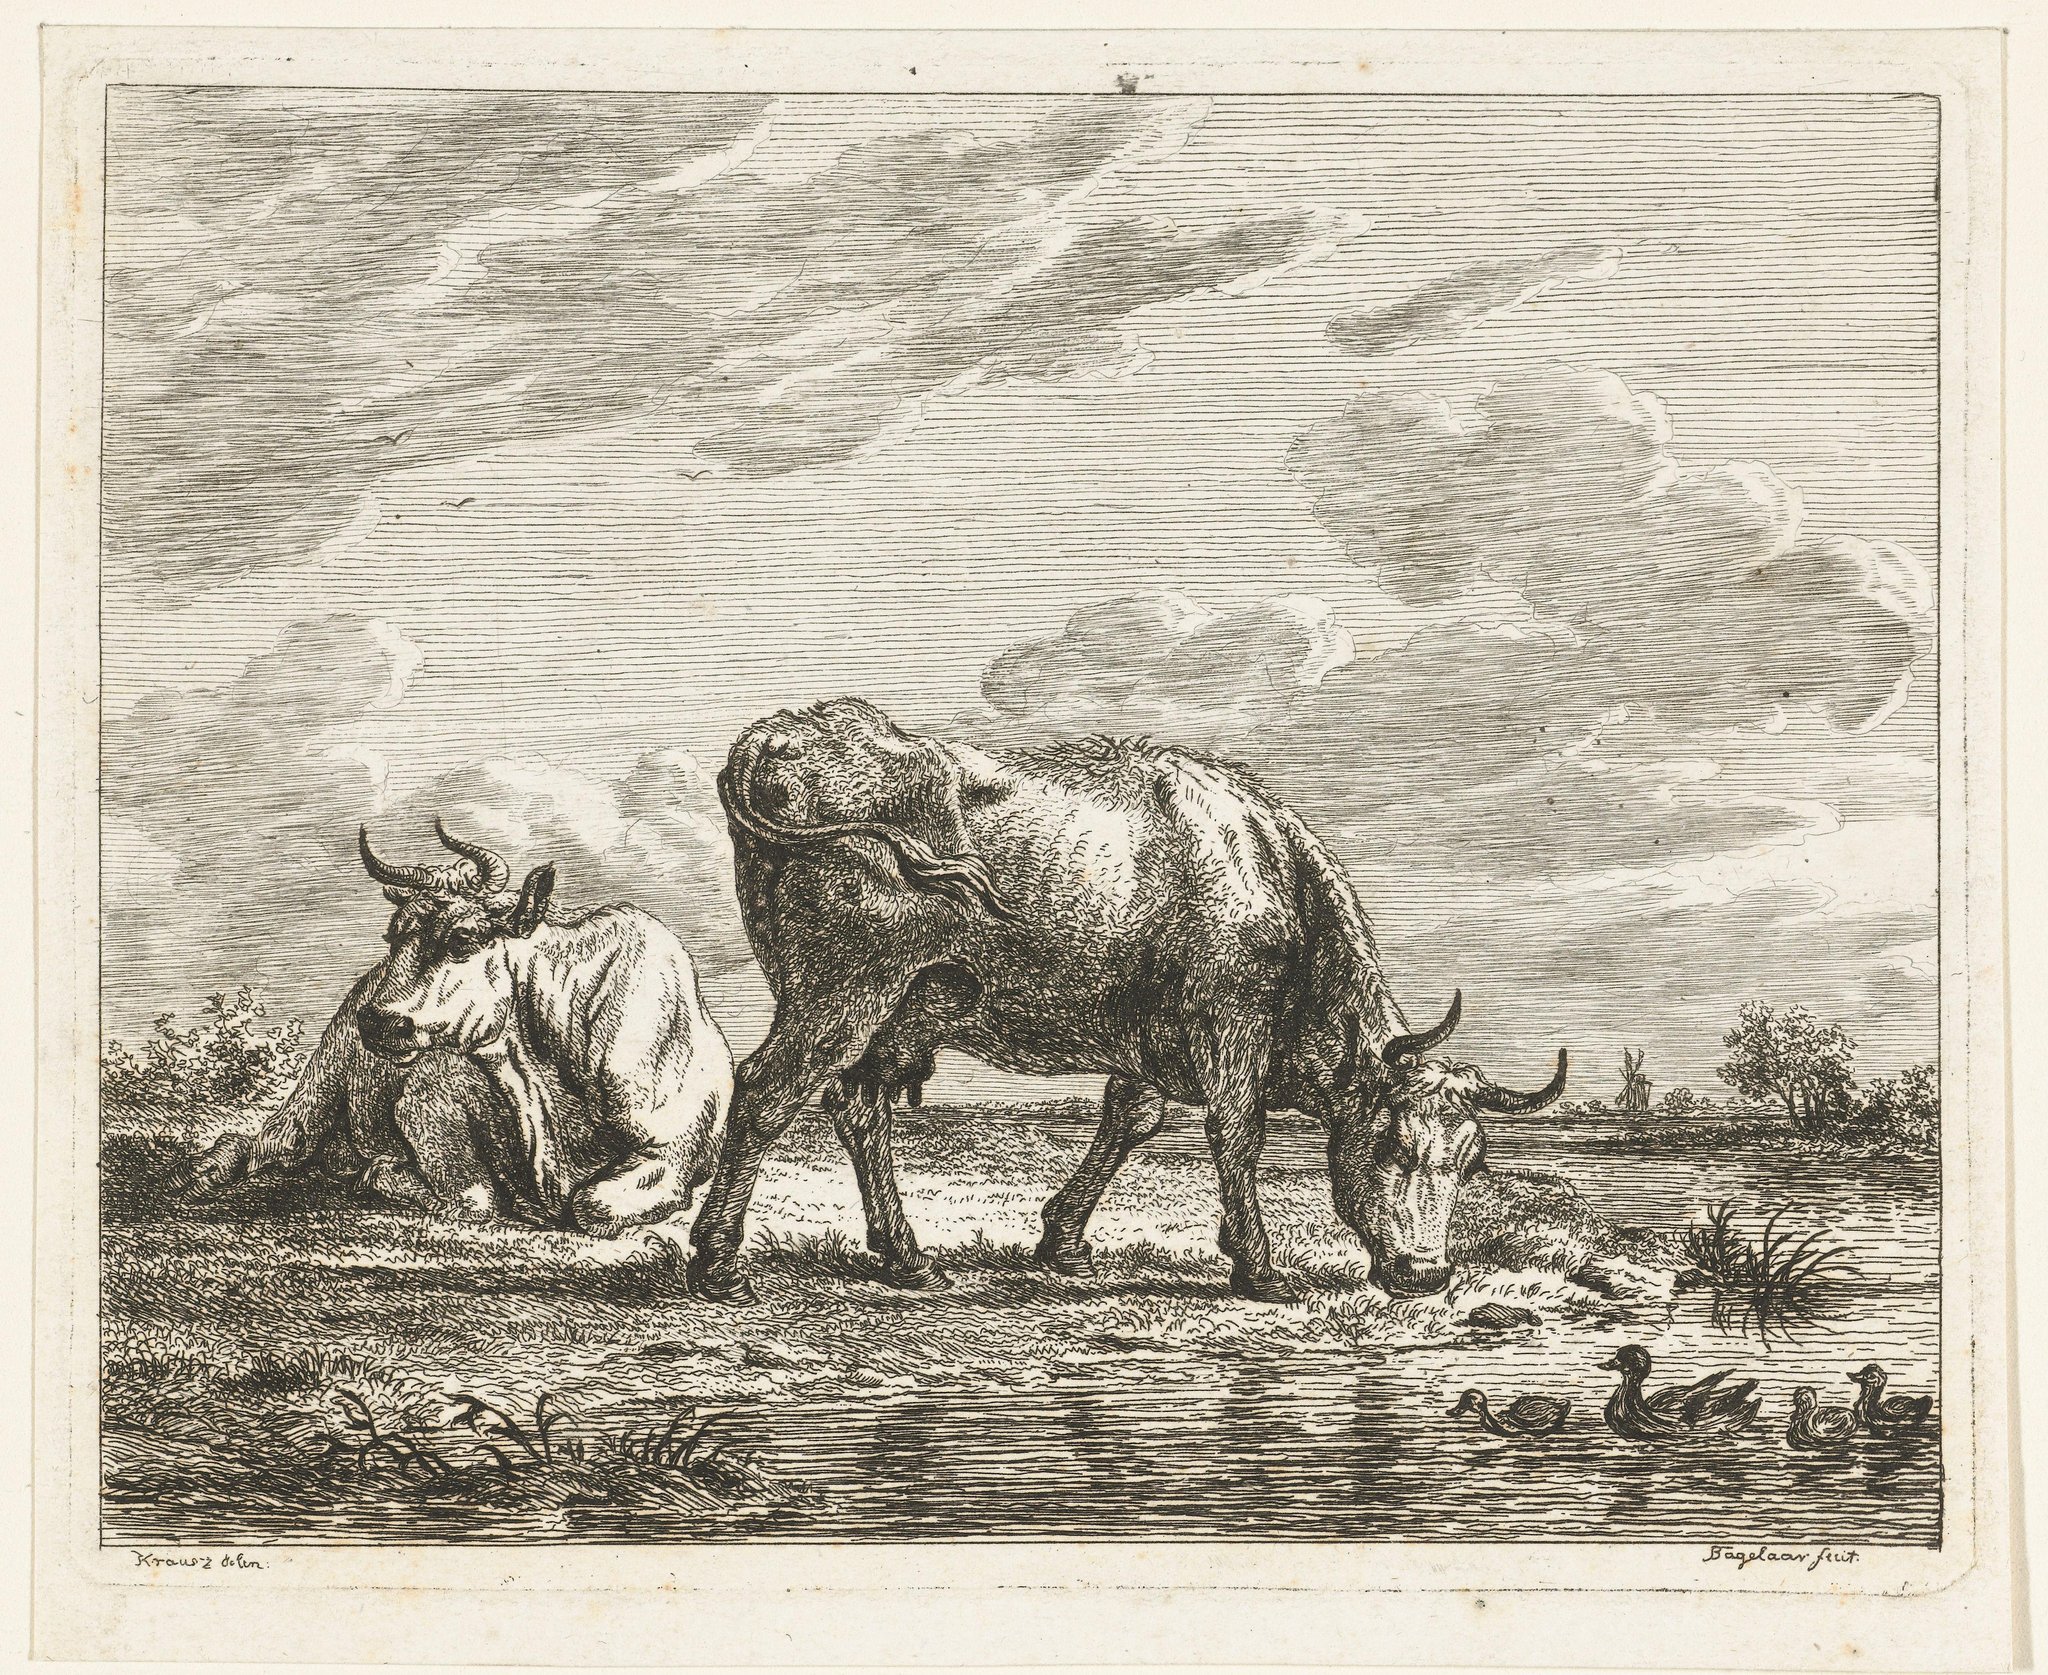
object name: print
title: Weiland met twee koeien bij een sloot met eenden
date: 1798-1837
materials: paper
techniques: drypoint, etching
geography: netherlands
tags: landscapes in the temperate zone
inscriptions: collector's mark: Lugt 2228